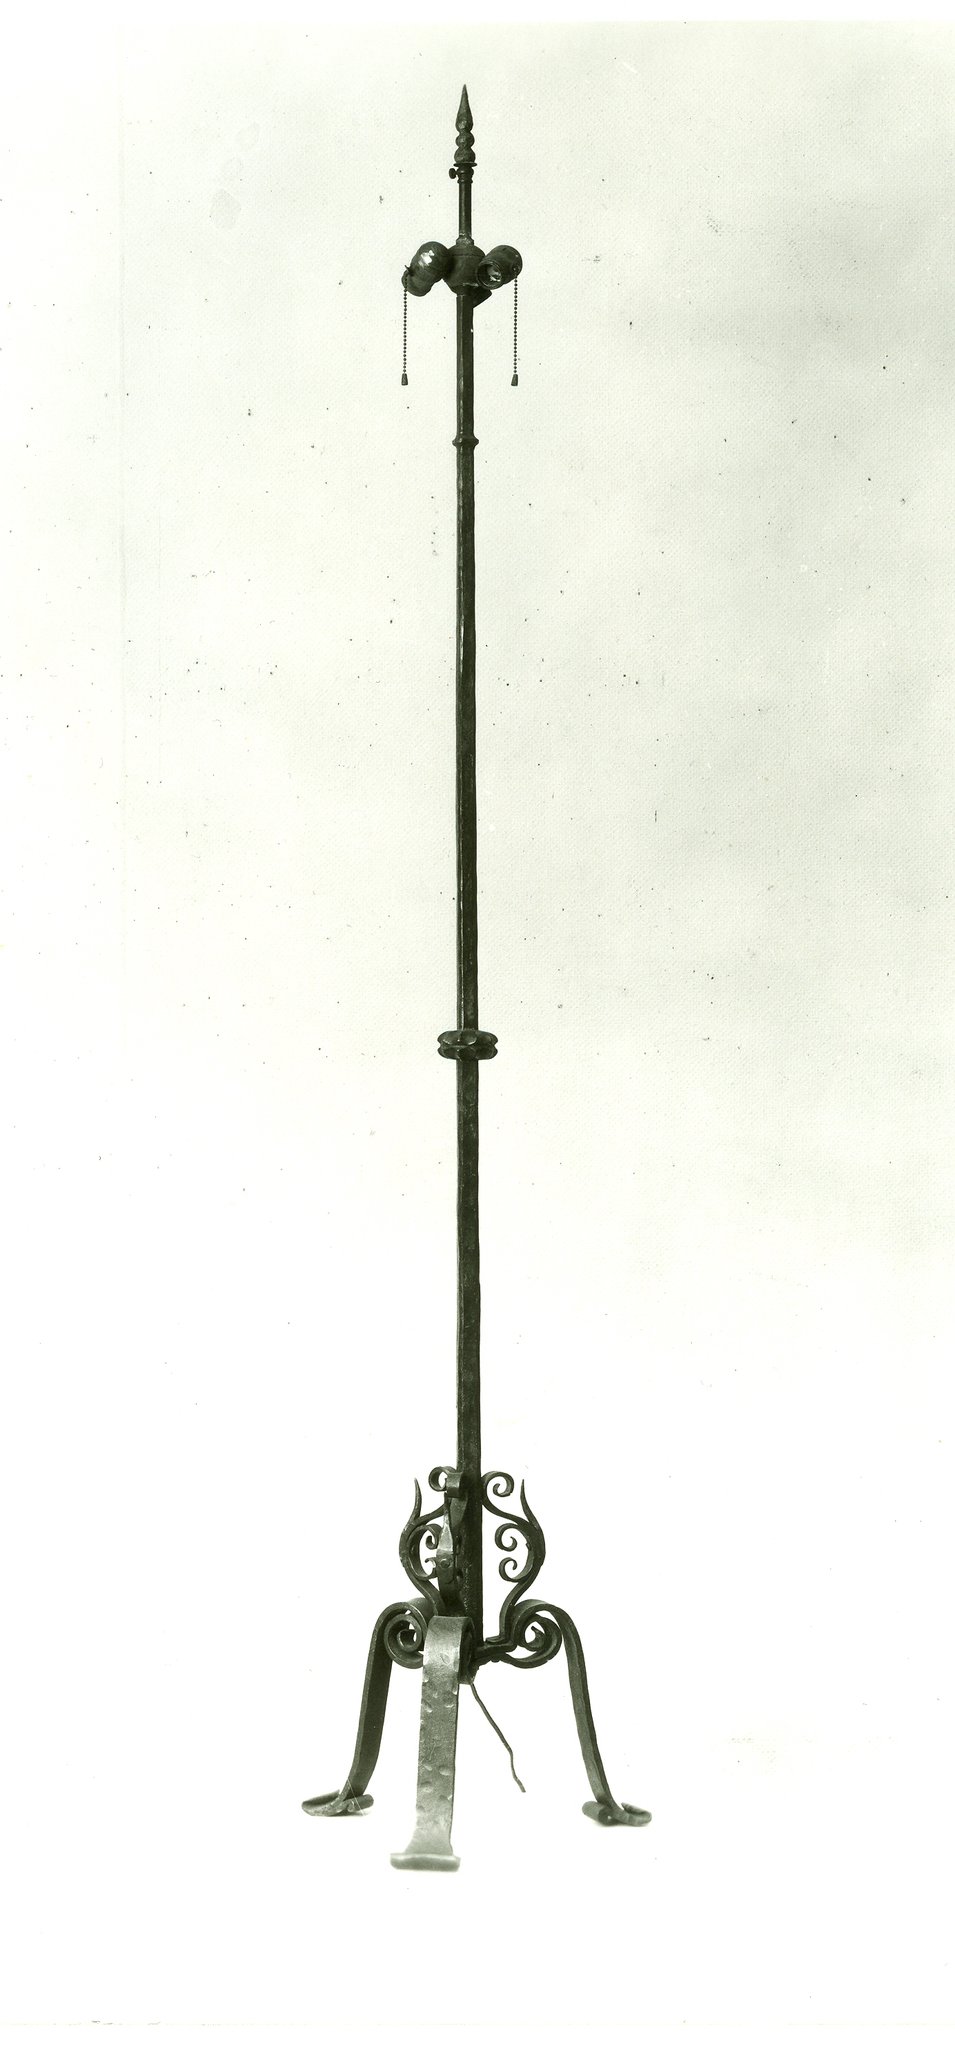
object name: candle pricket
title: Candle pricket (pair with 1975.1.1463)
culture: spanish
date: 1601-1700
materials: iron